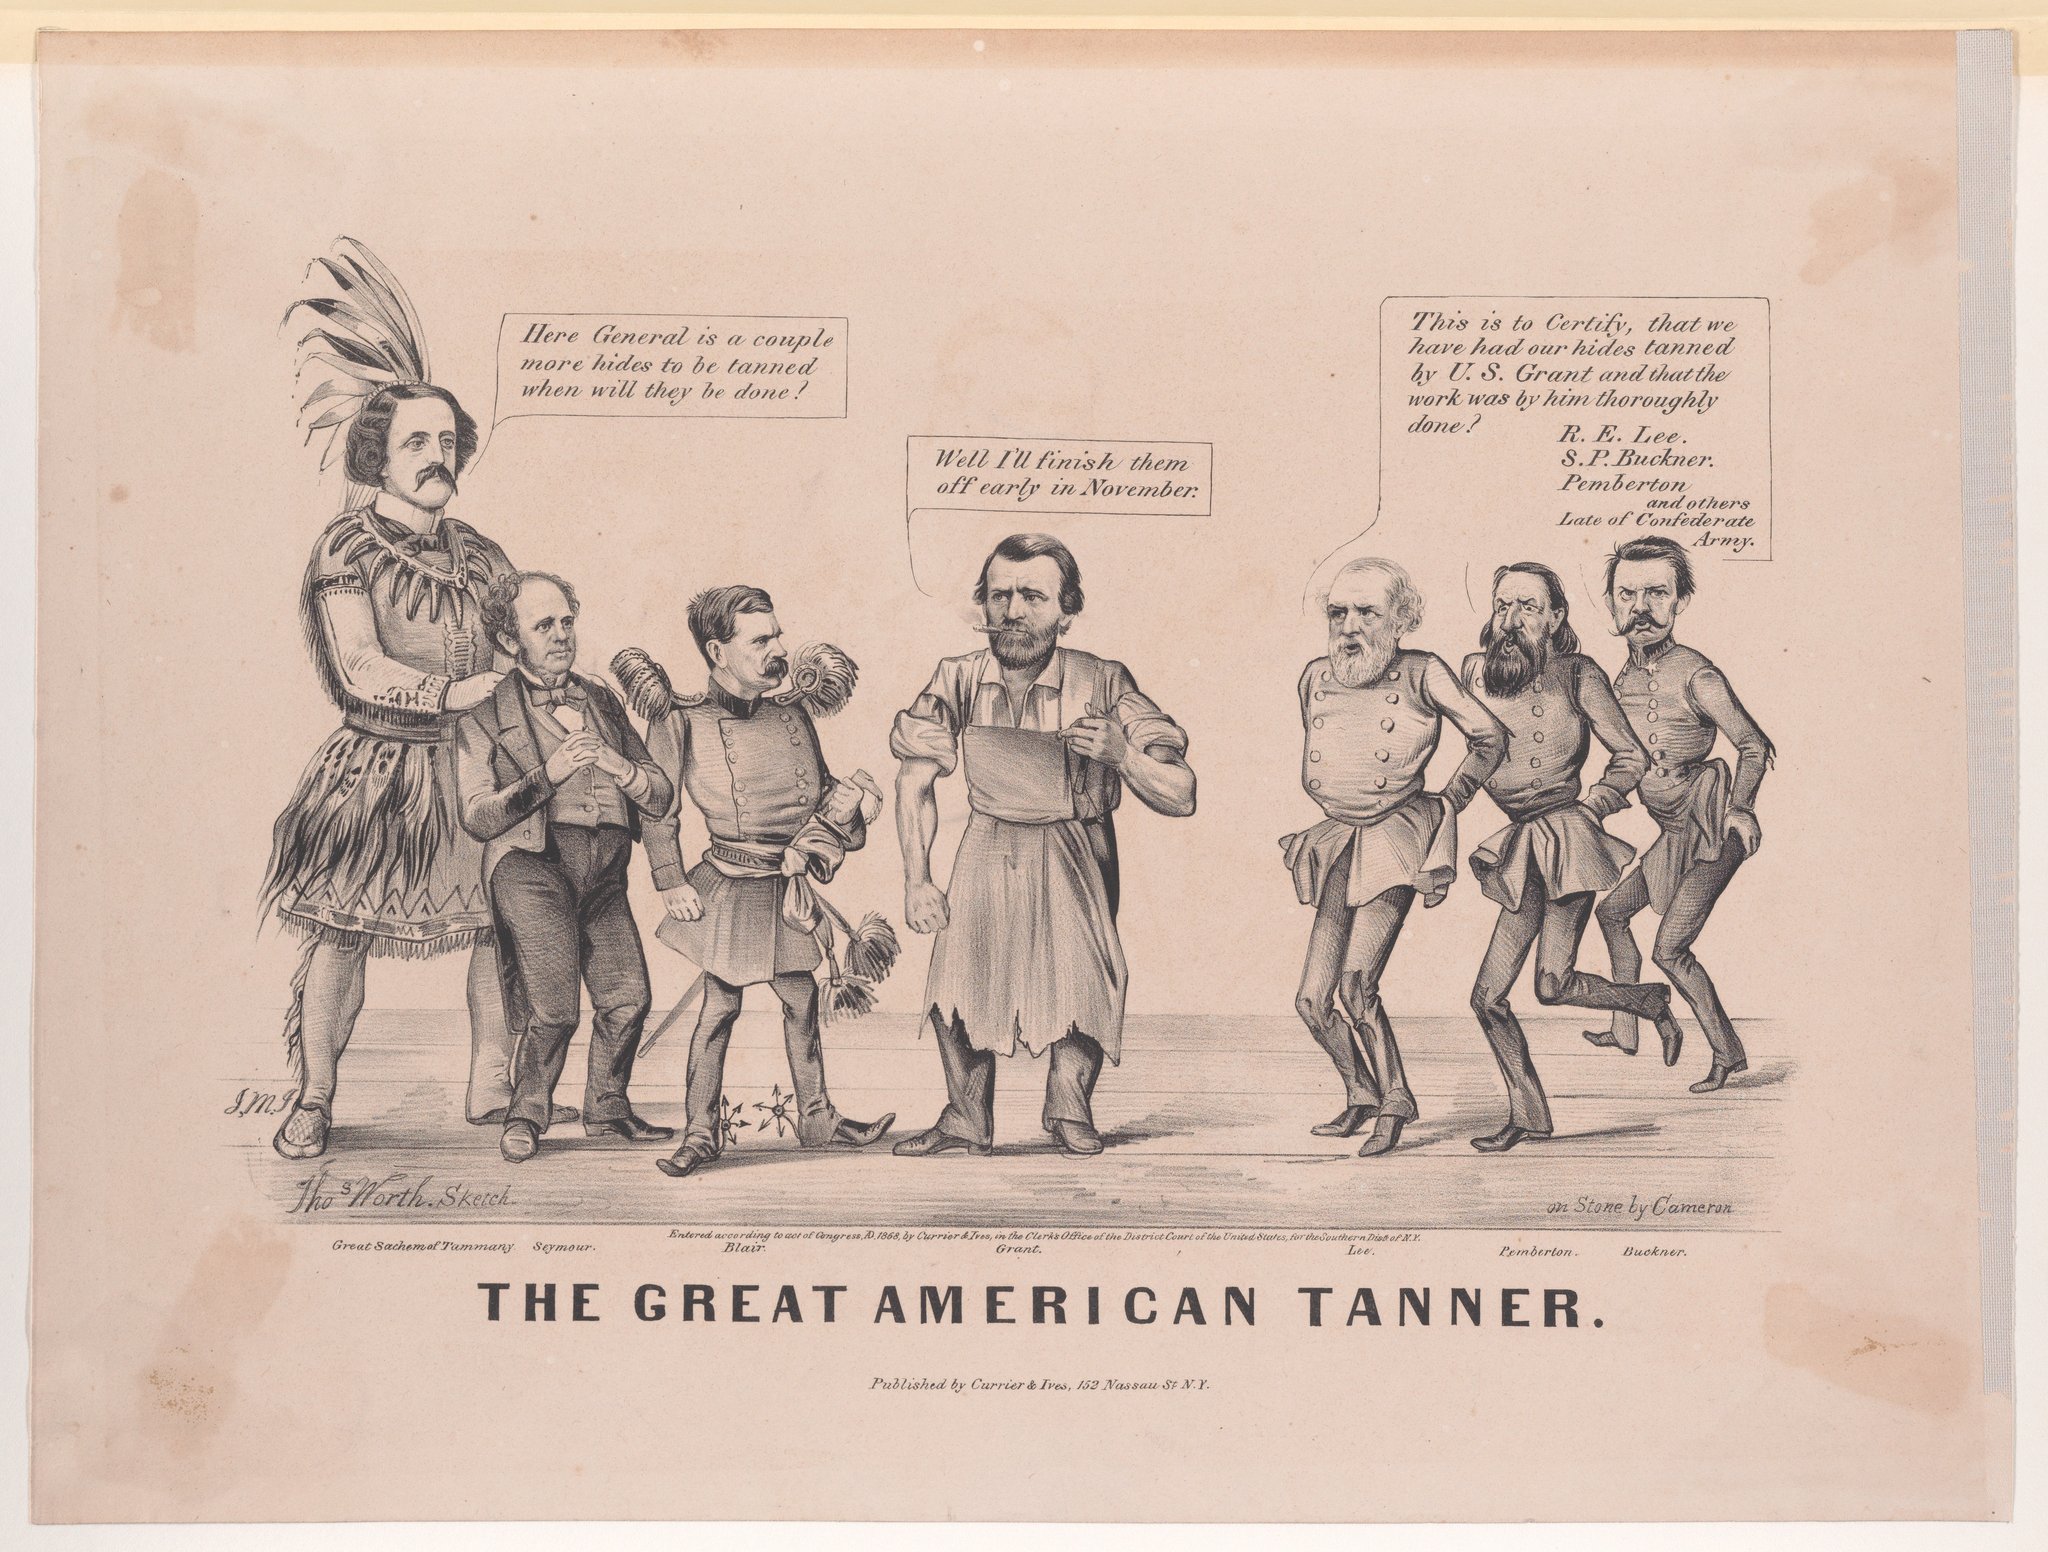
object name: print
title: The Great American Tanner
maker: thomas b. worth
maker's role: artist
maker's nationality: american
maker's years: 1834-1917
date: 1868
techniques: lithograph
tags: satire,men,generals,politics